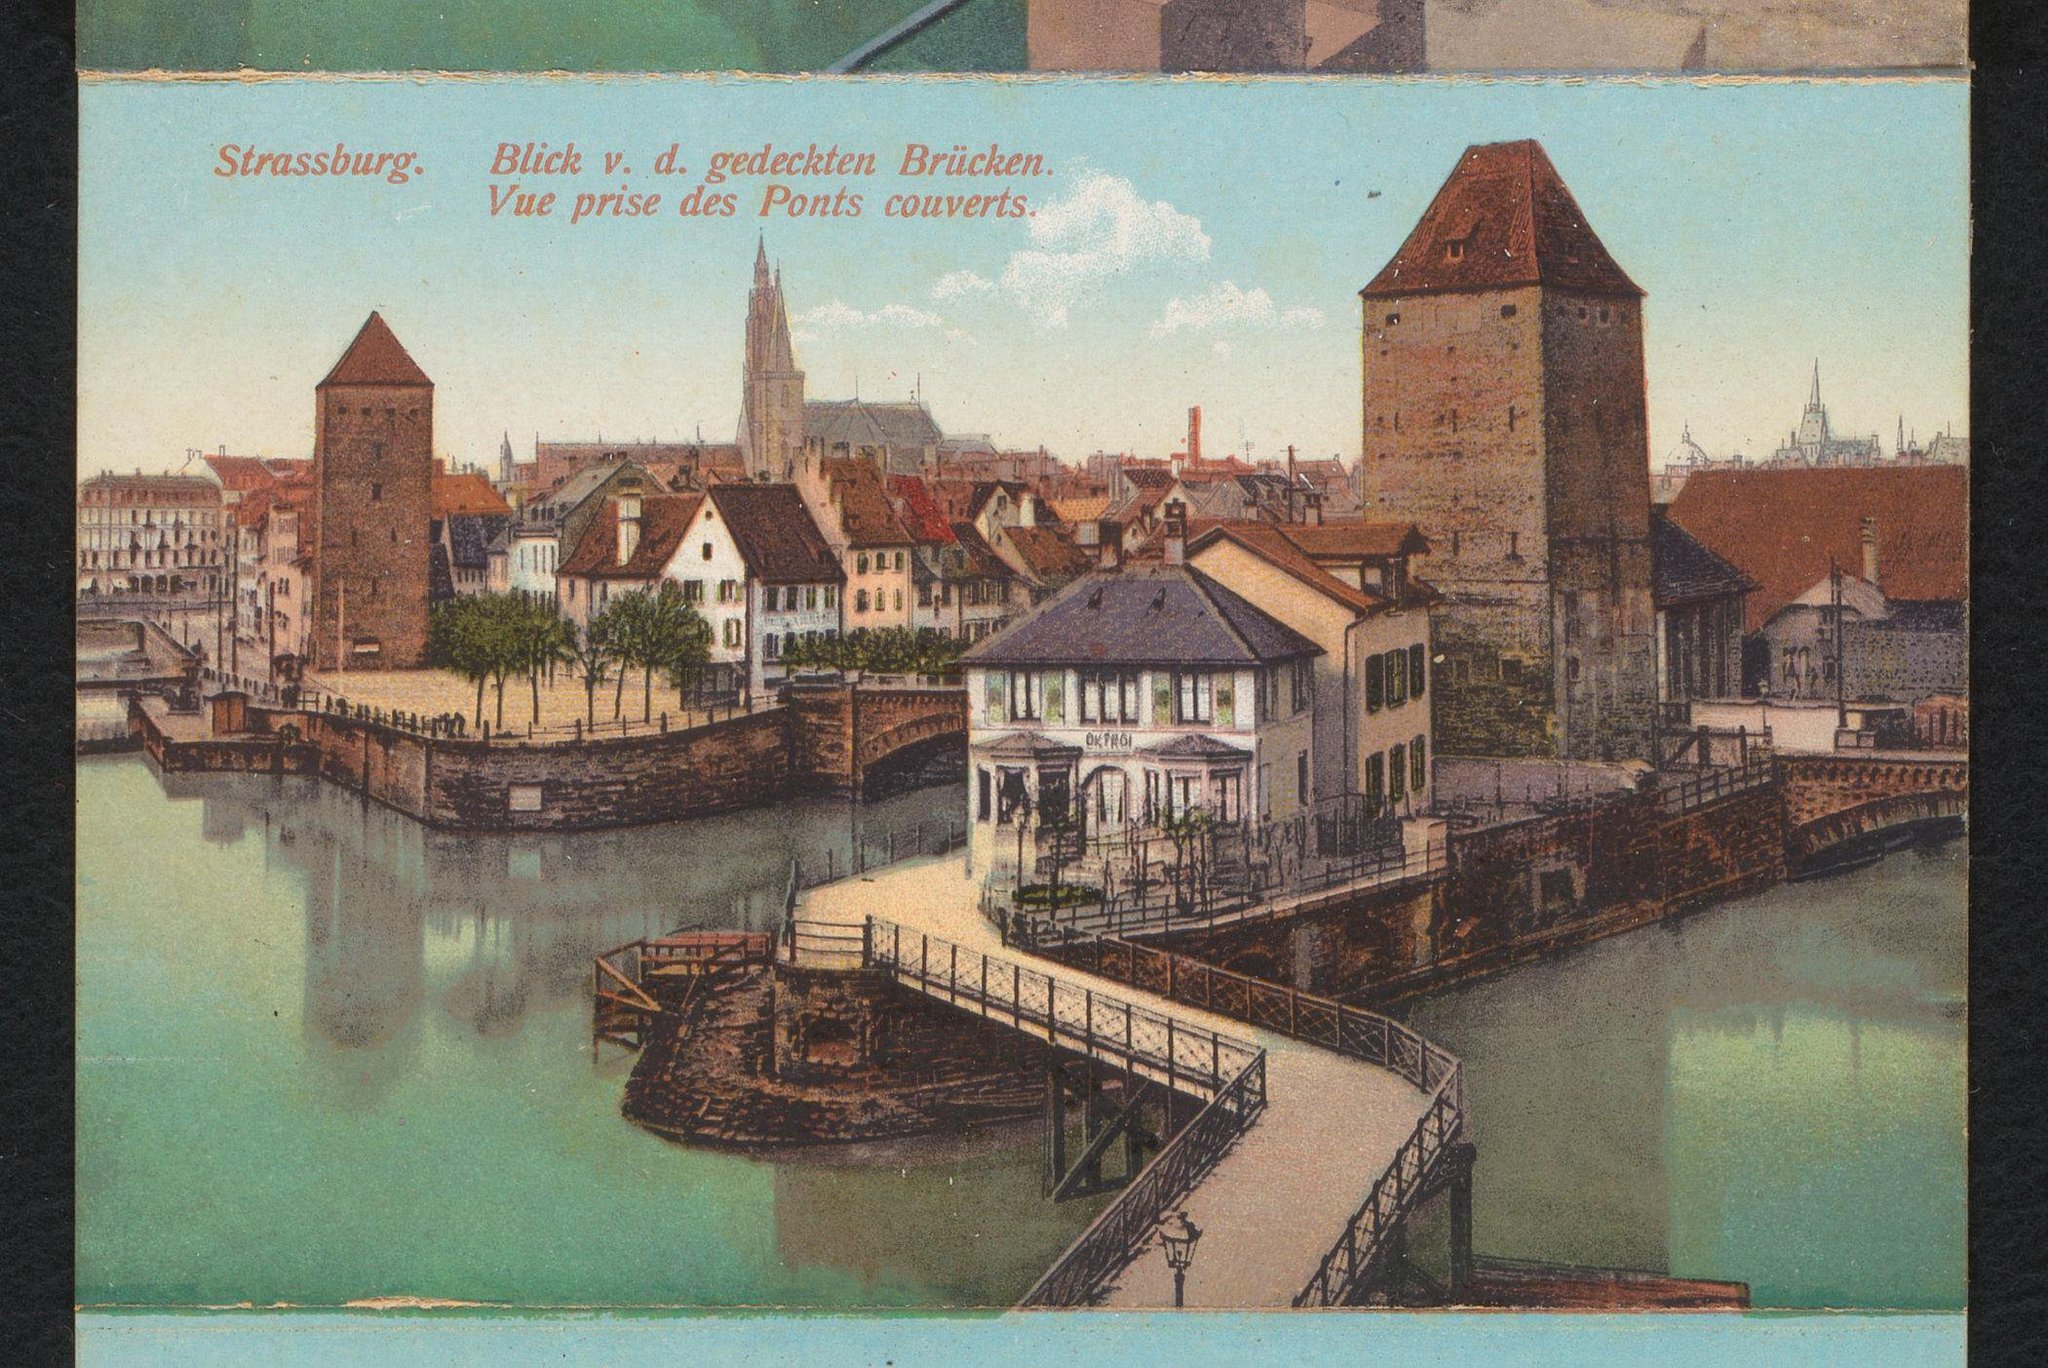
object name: ansichtkaart, prentbriefkaart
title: Strassburg. Blick v. d. gedeckten Brücken / Vue prise des Ponts couverts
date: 1905-1930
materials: cardboard, photographic process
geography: straatsburg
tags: city-view, and landscape with man-made constructions, canals, waters (in city), bridge in city across river, canal, etc.